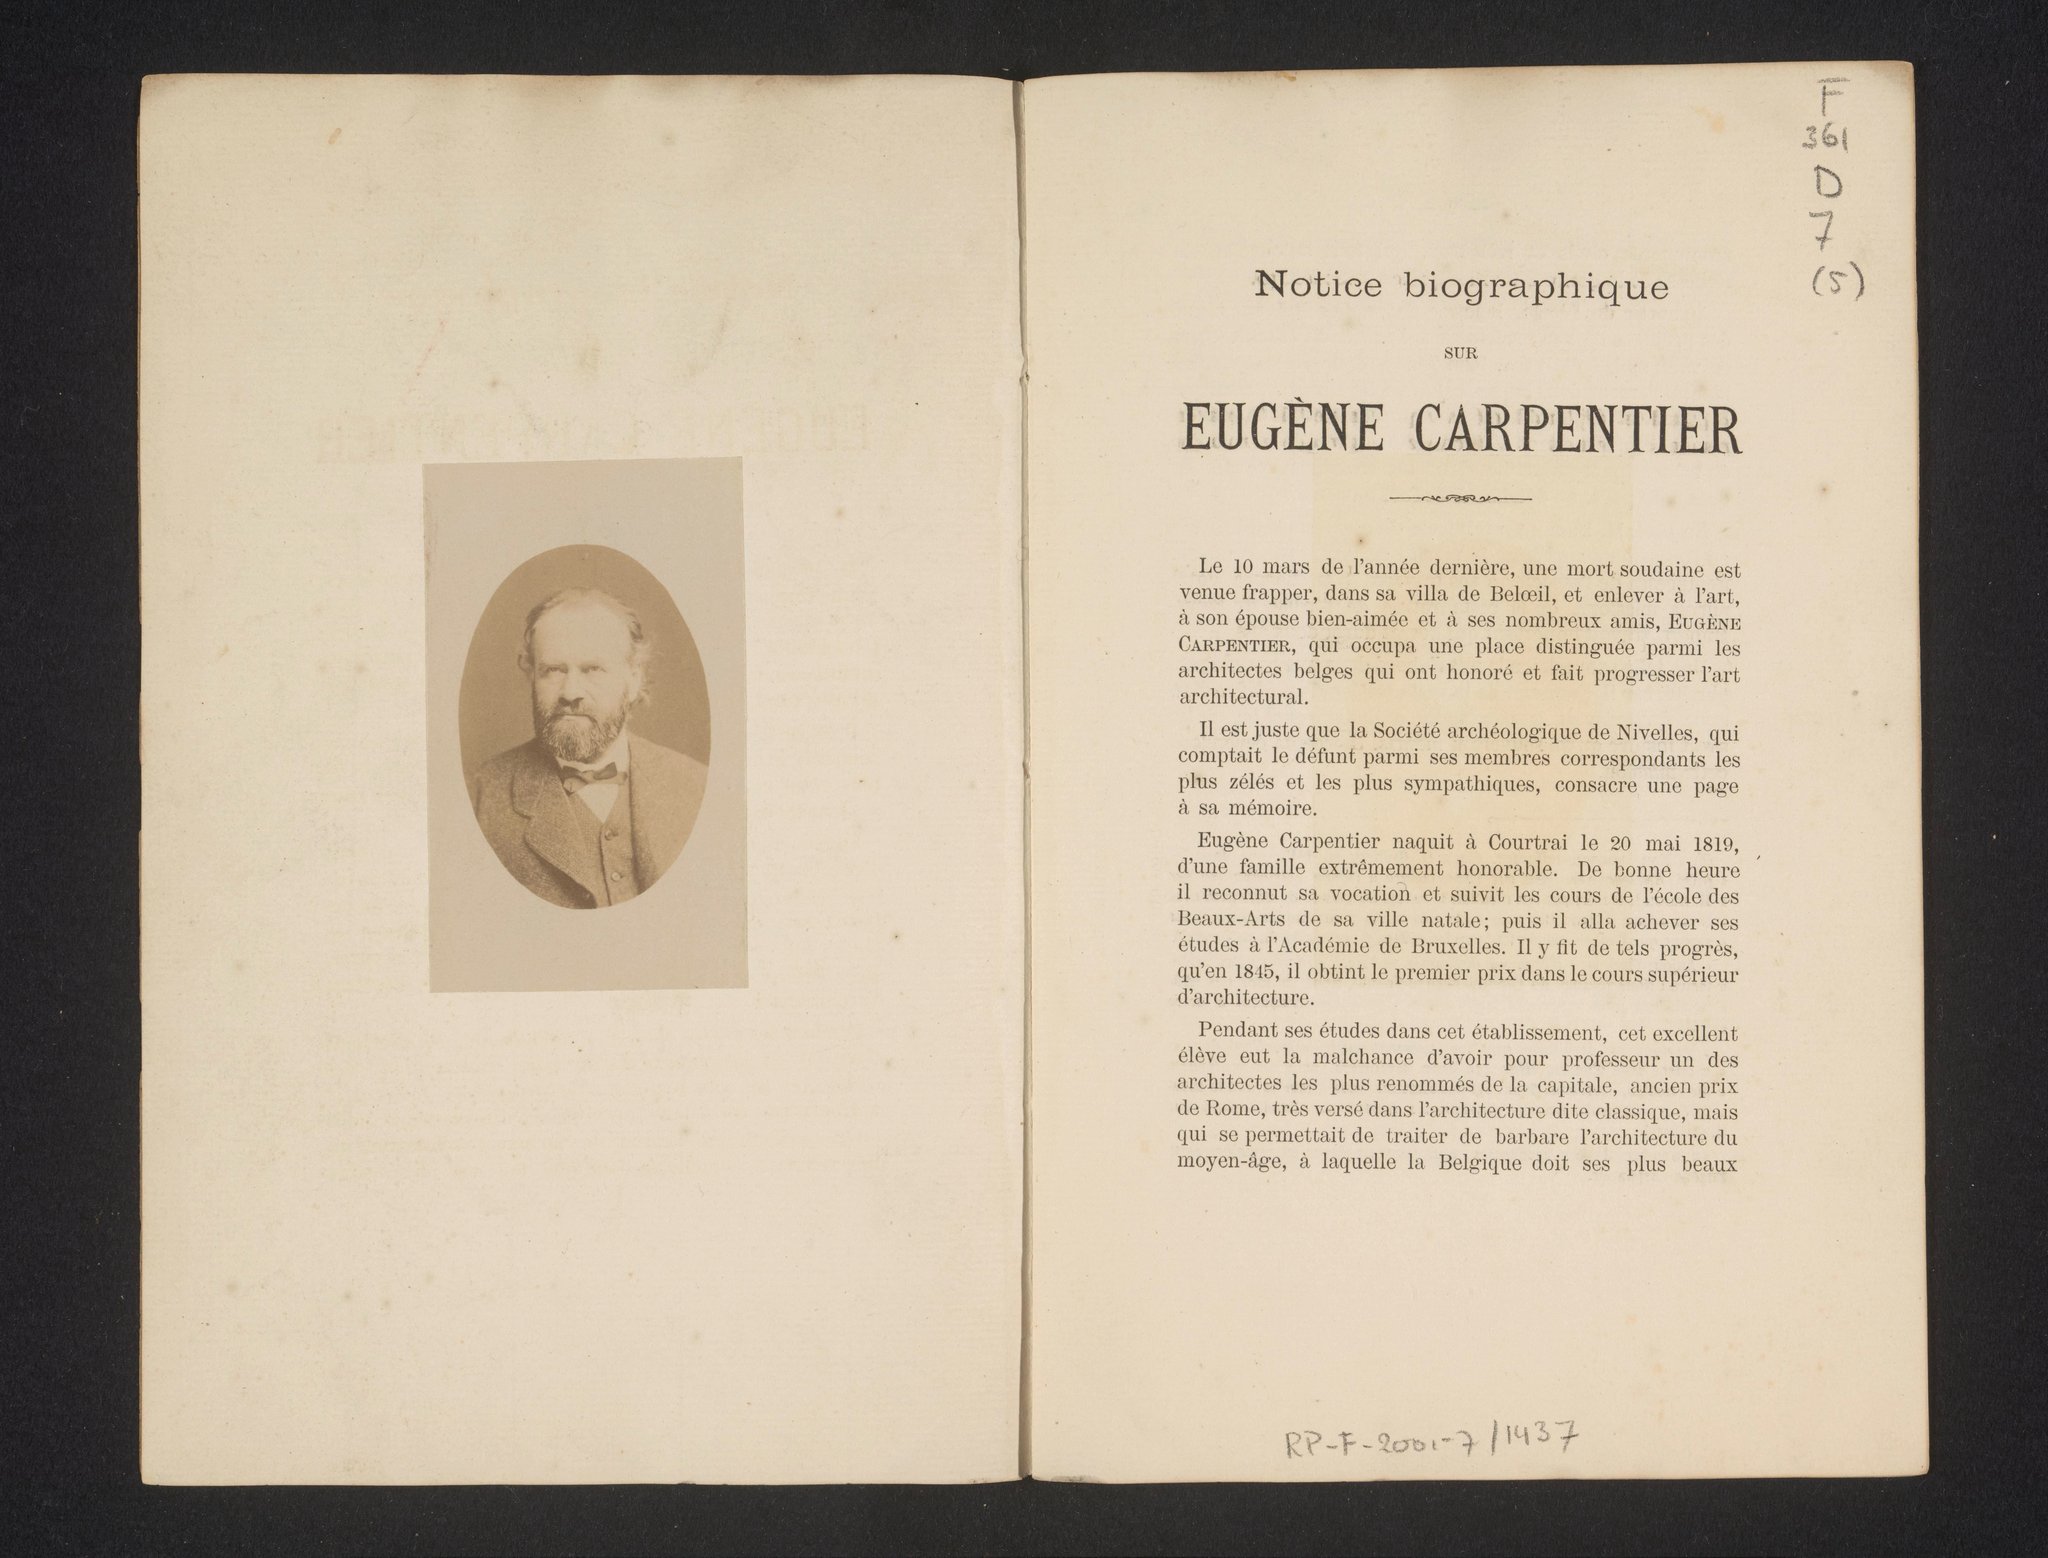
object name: photograph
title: Portret van Eugène Carpentier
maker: Anonymous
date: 1884-1889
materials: photographic support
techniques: albumen print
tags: eugène carpentier, historical persons, portrait, self-portrait of architect